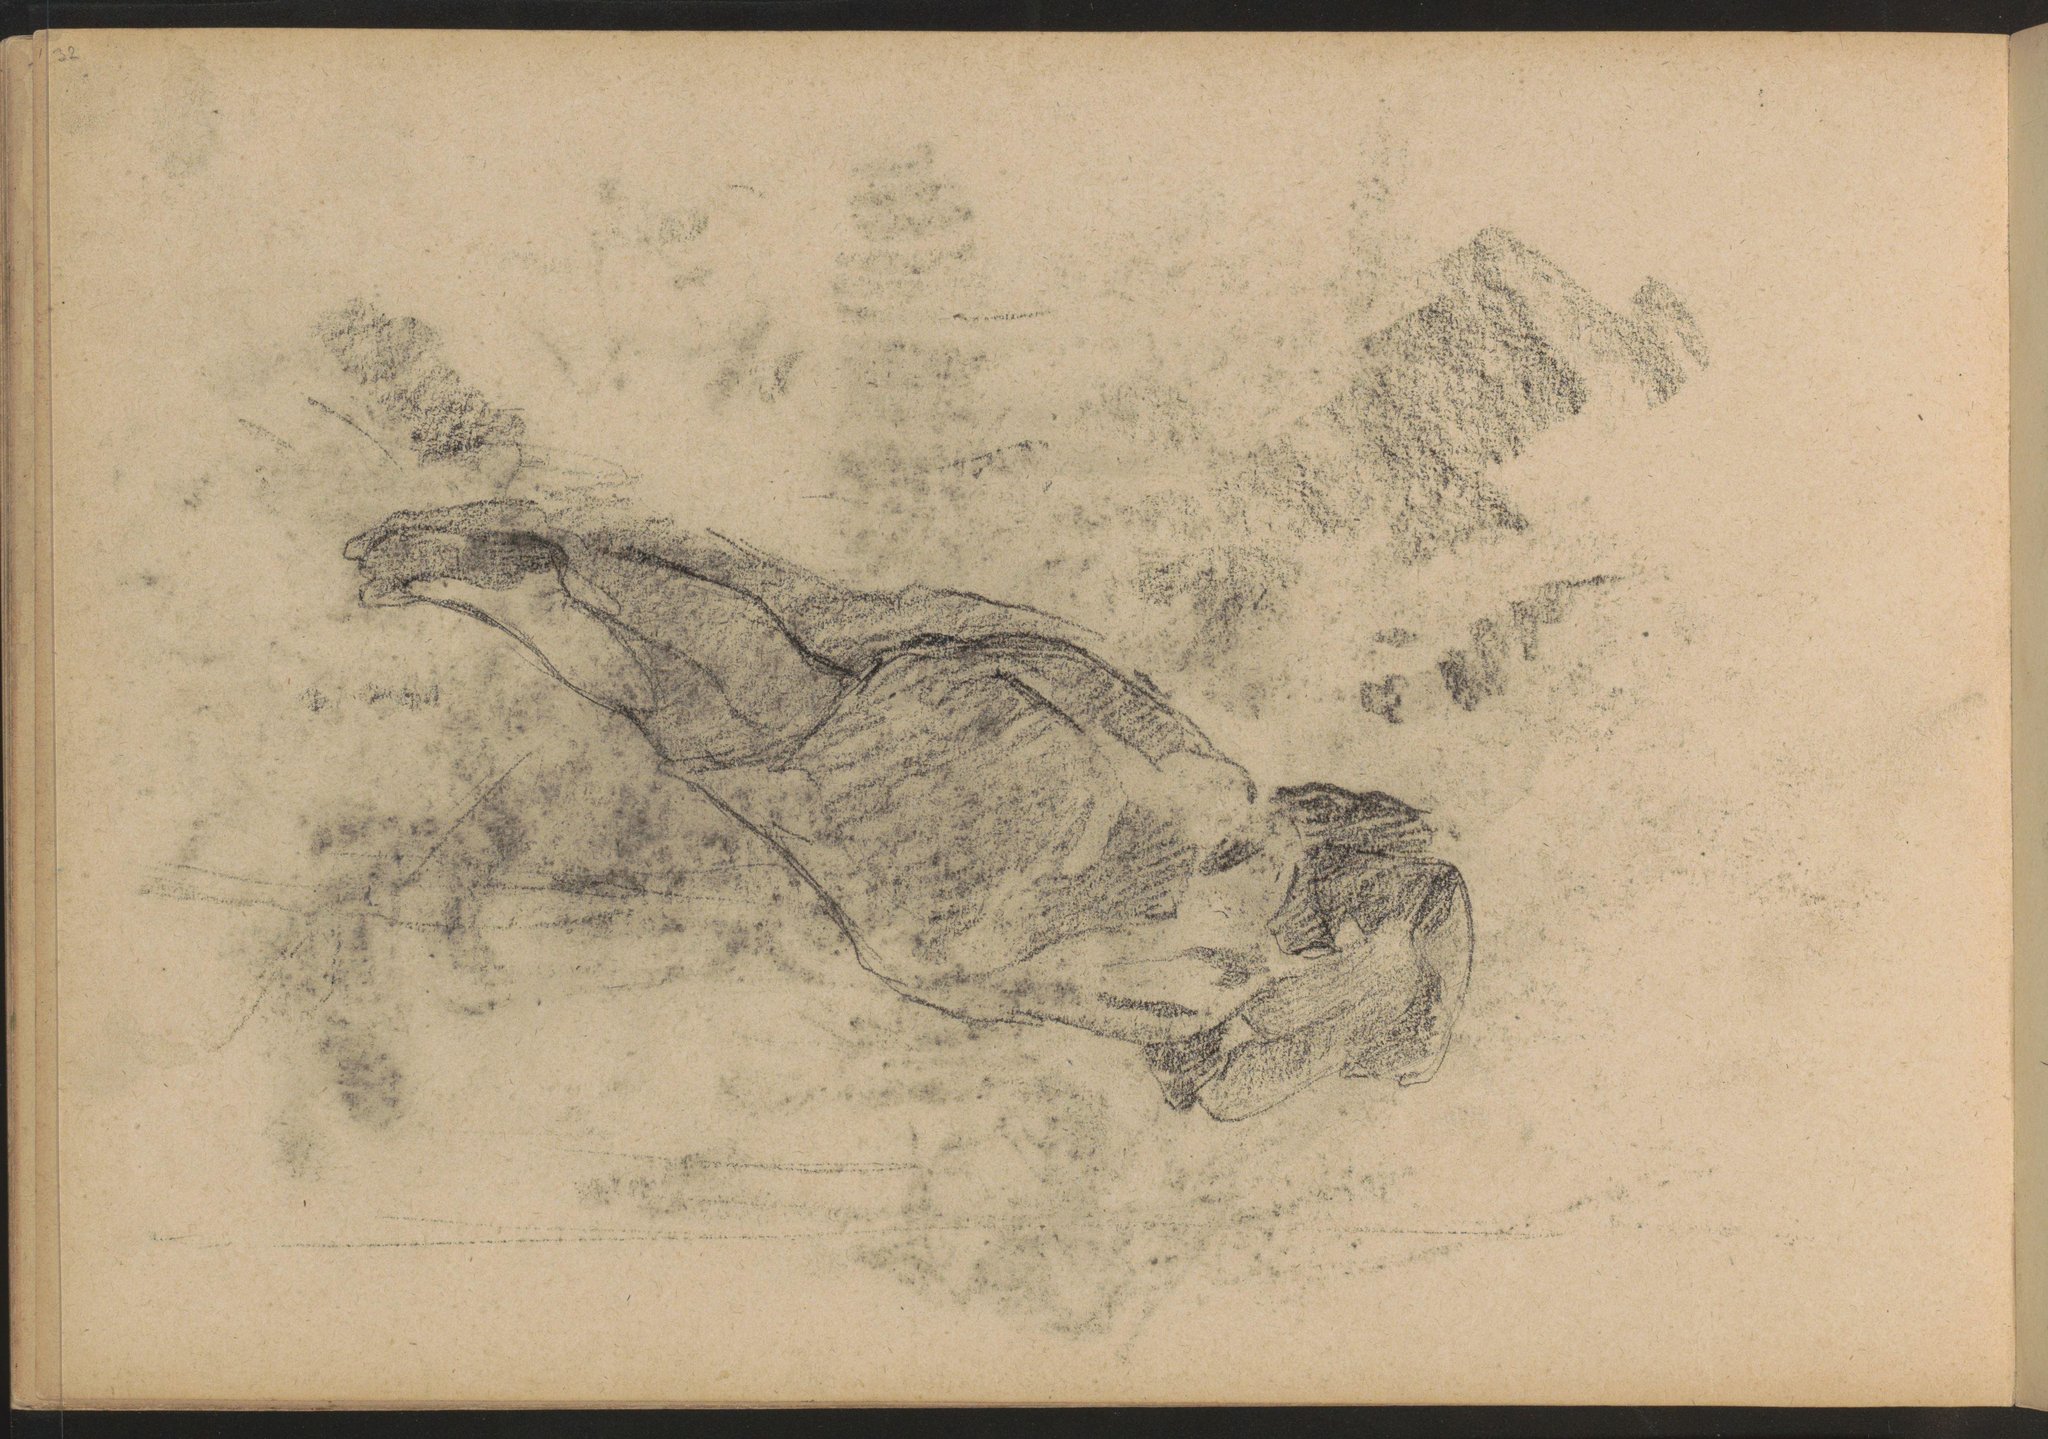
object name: sketchbook leaf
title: Liggende vrouw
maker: willem witsen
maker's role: draughtsman, painter, print maker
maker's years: 1860-1923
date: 1884-1887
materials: chalk, paper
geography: ewijkshoeve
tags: landscapes in the temperate zone, lying figure - aa - female human figure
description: Mogelijk slapend. Pagina 32 uit een schetsboek met 29 bladen.